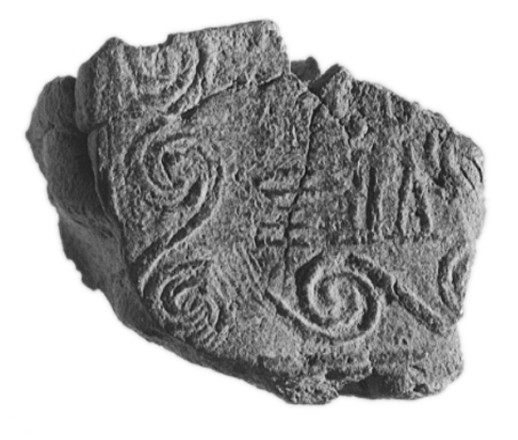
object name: sealing, administrative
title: Sealing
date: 1981-1640 BCE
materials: clay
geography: egypt